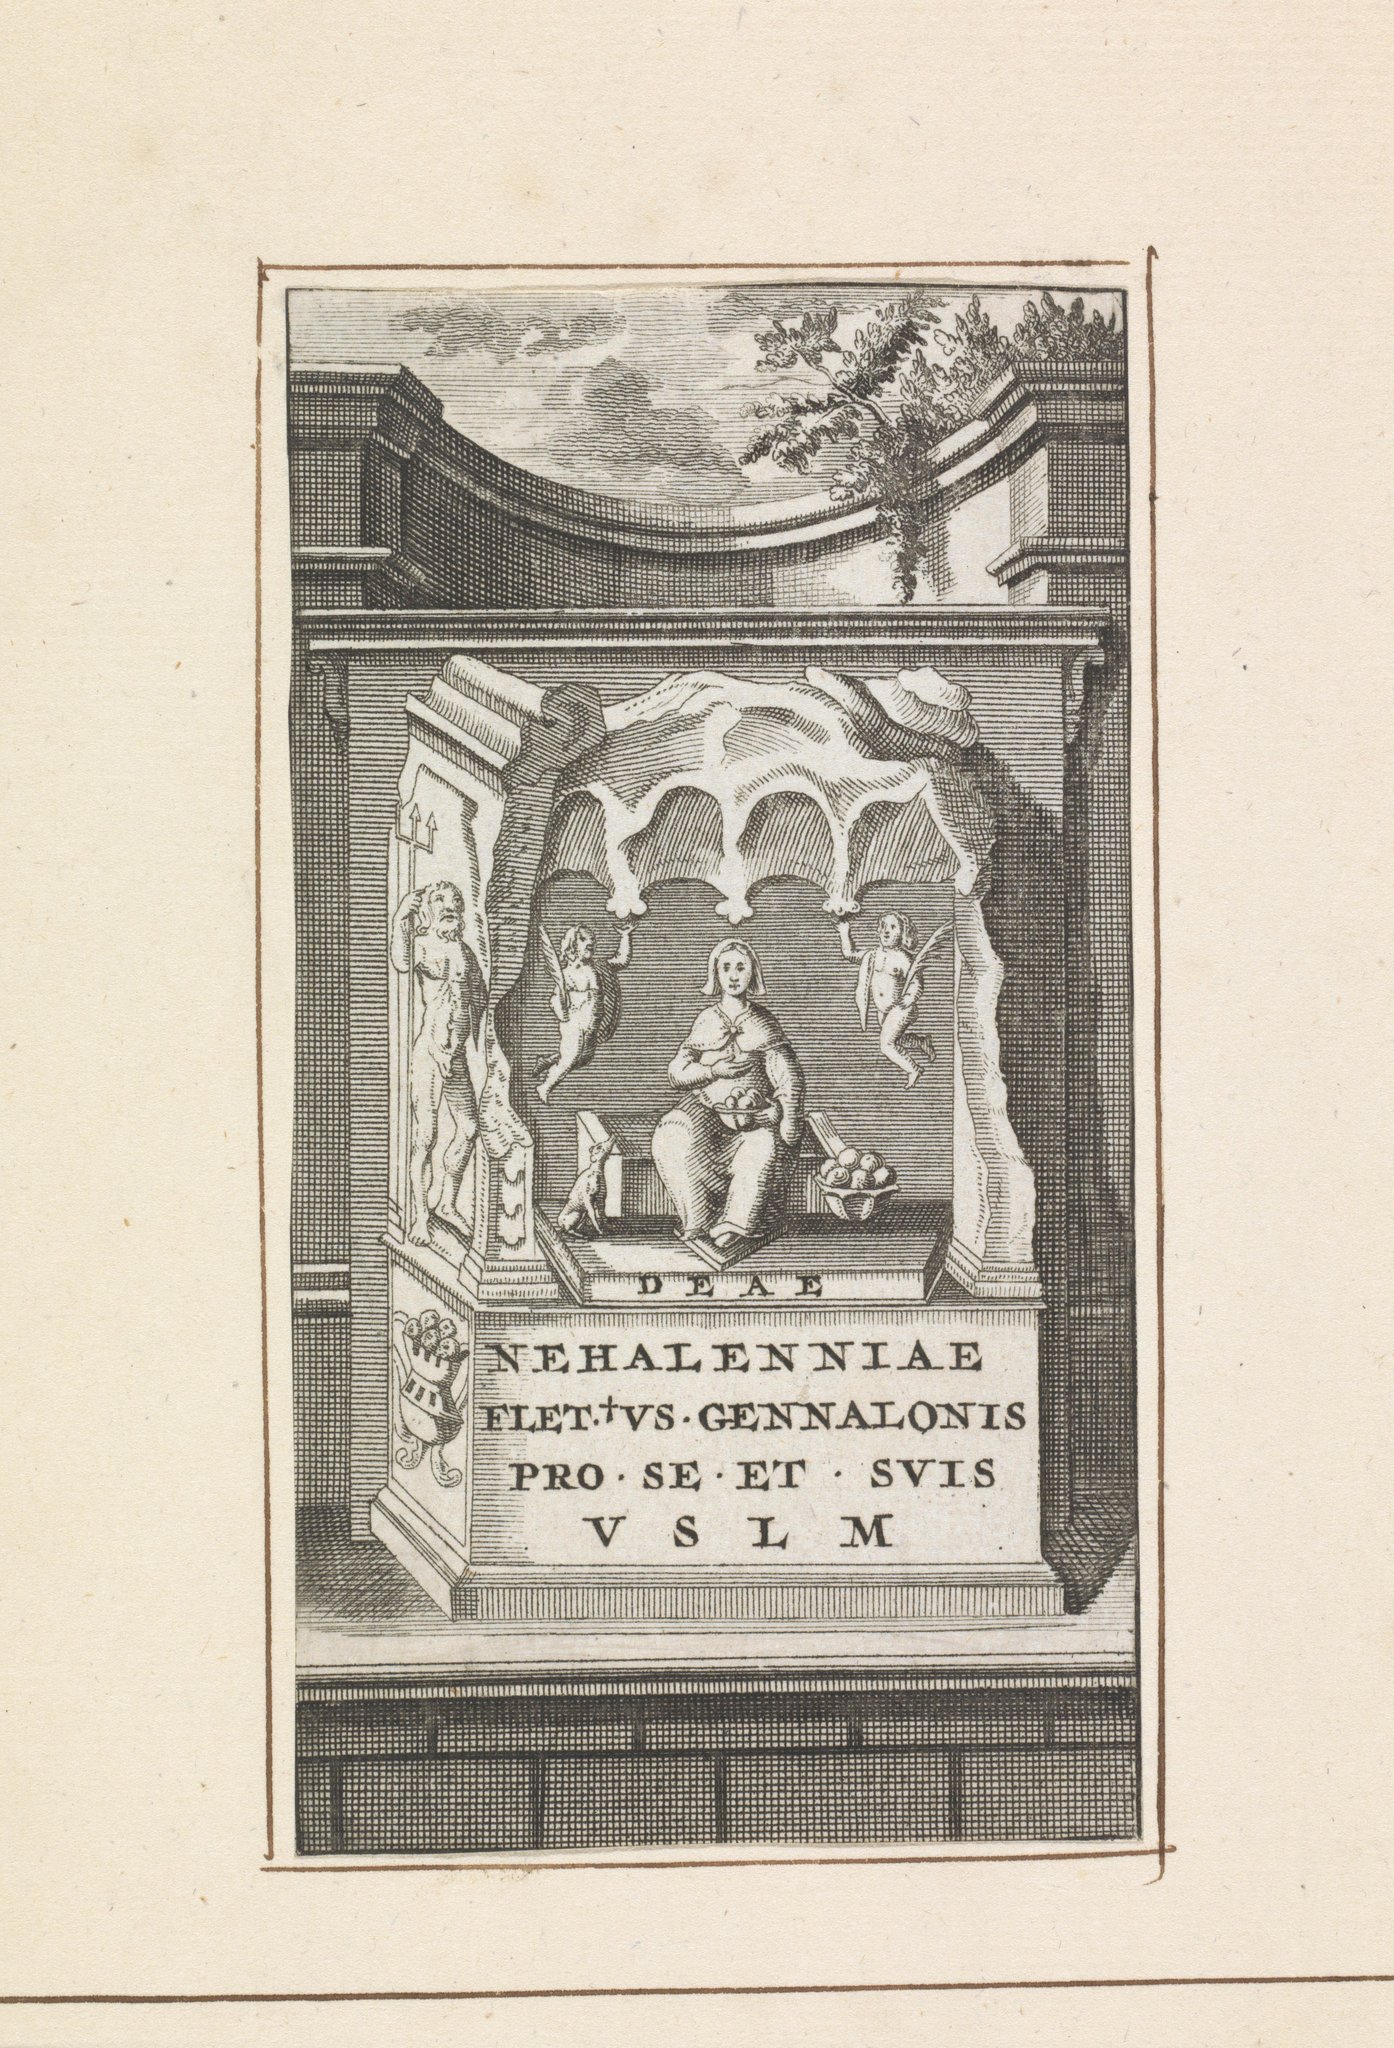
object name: print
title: Nehalennia-altaar met gezeten Nehalennia en twee vliegende figuren met palmtakken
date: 1715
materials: paper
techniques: etching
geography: leiden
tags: other foreign deities included in the classical pantheon (with name)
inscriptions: collector's mark: Lugt 2228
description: Een Nehalennia-altaar dat is gevonden bij Domburg op Walcheren. De godin Nehalennia zitteend met een mand vruchten op haar schoot en een mand naast haar. Links haar hond. Links en rechts vliegende figuren met palmtakken.